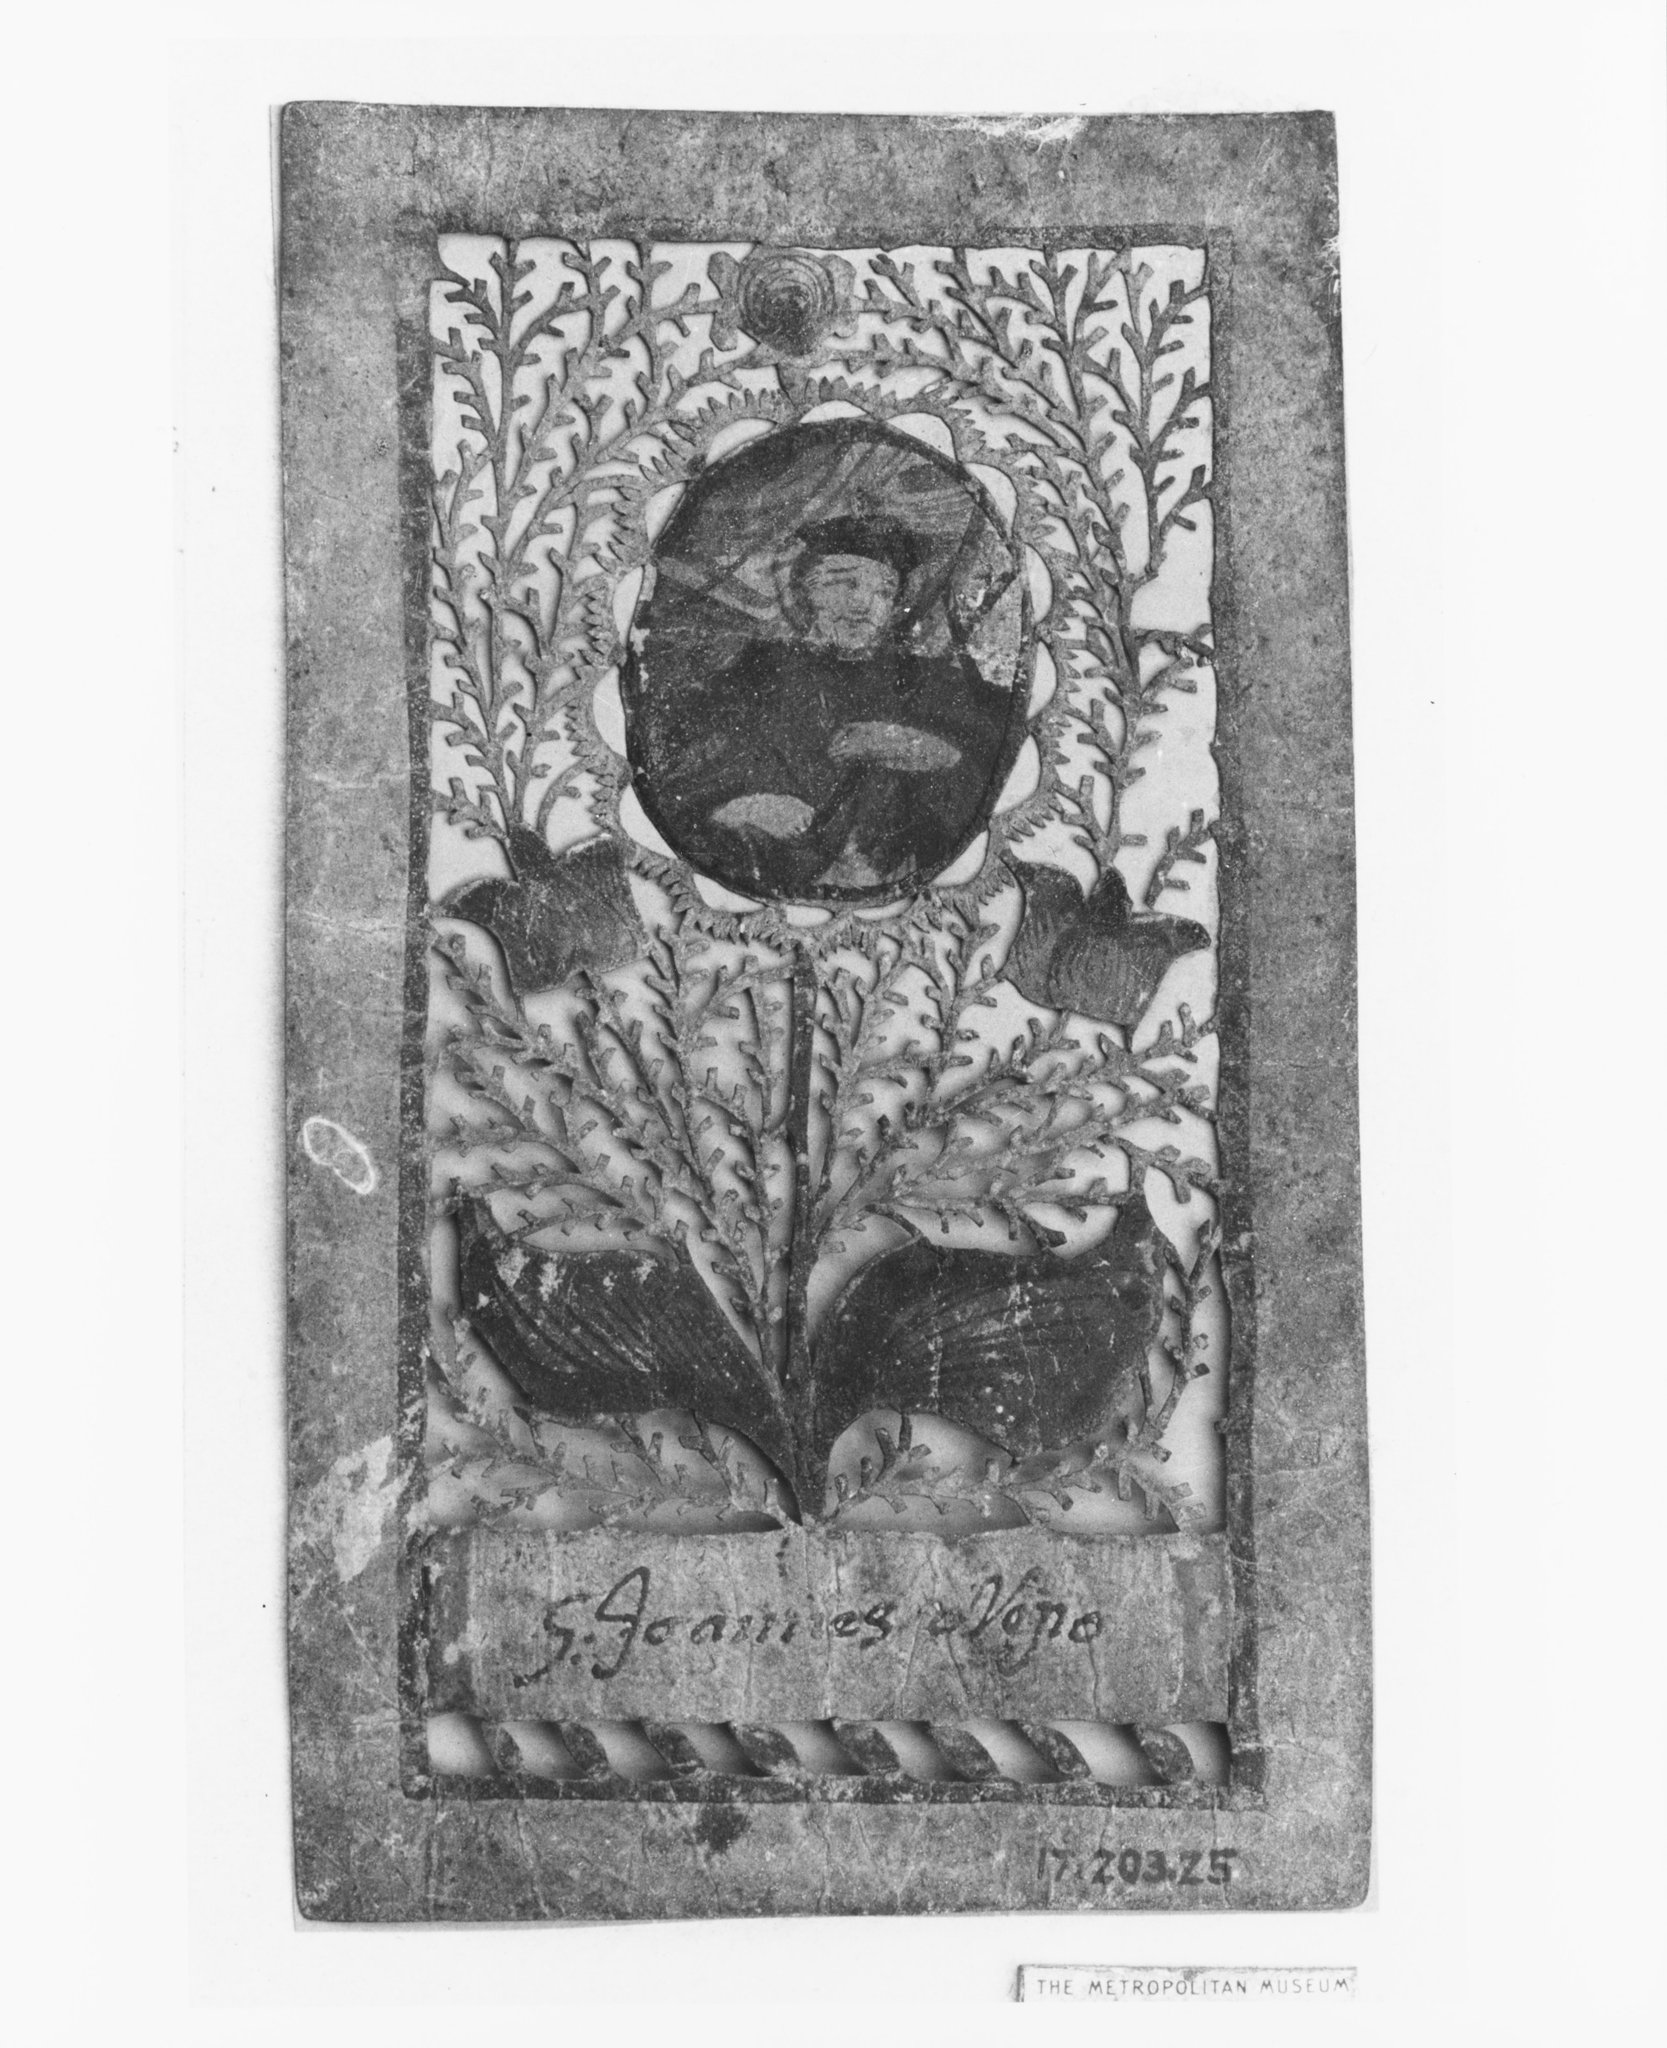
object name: card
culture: american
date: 1800-1830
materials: paper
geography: united states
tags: men,portraits,flowers,leaves